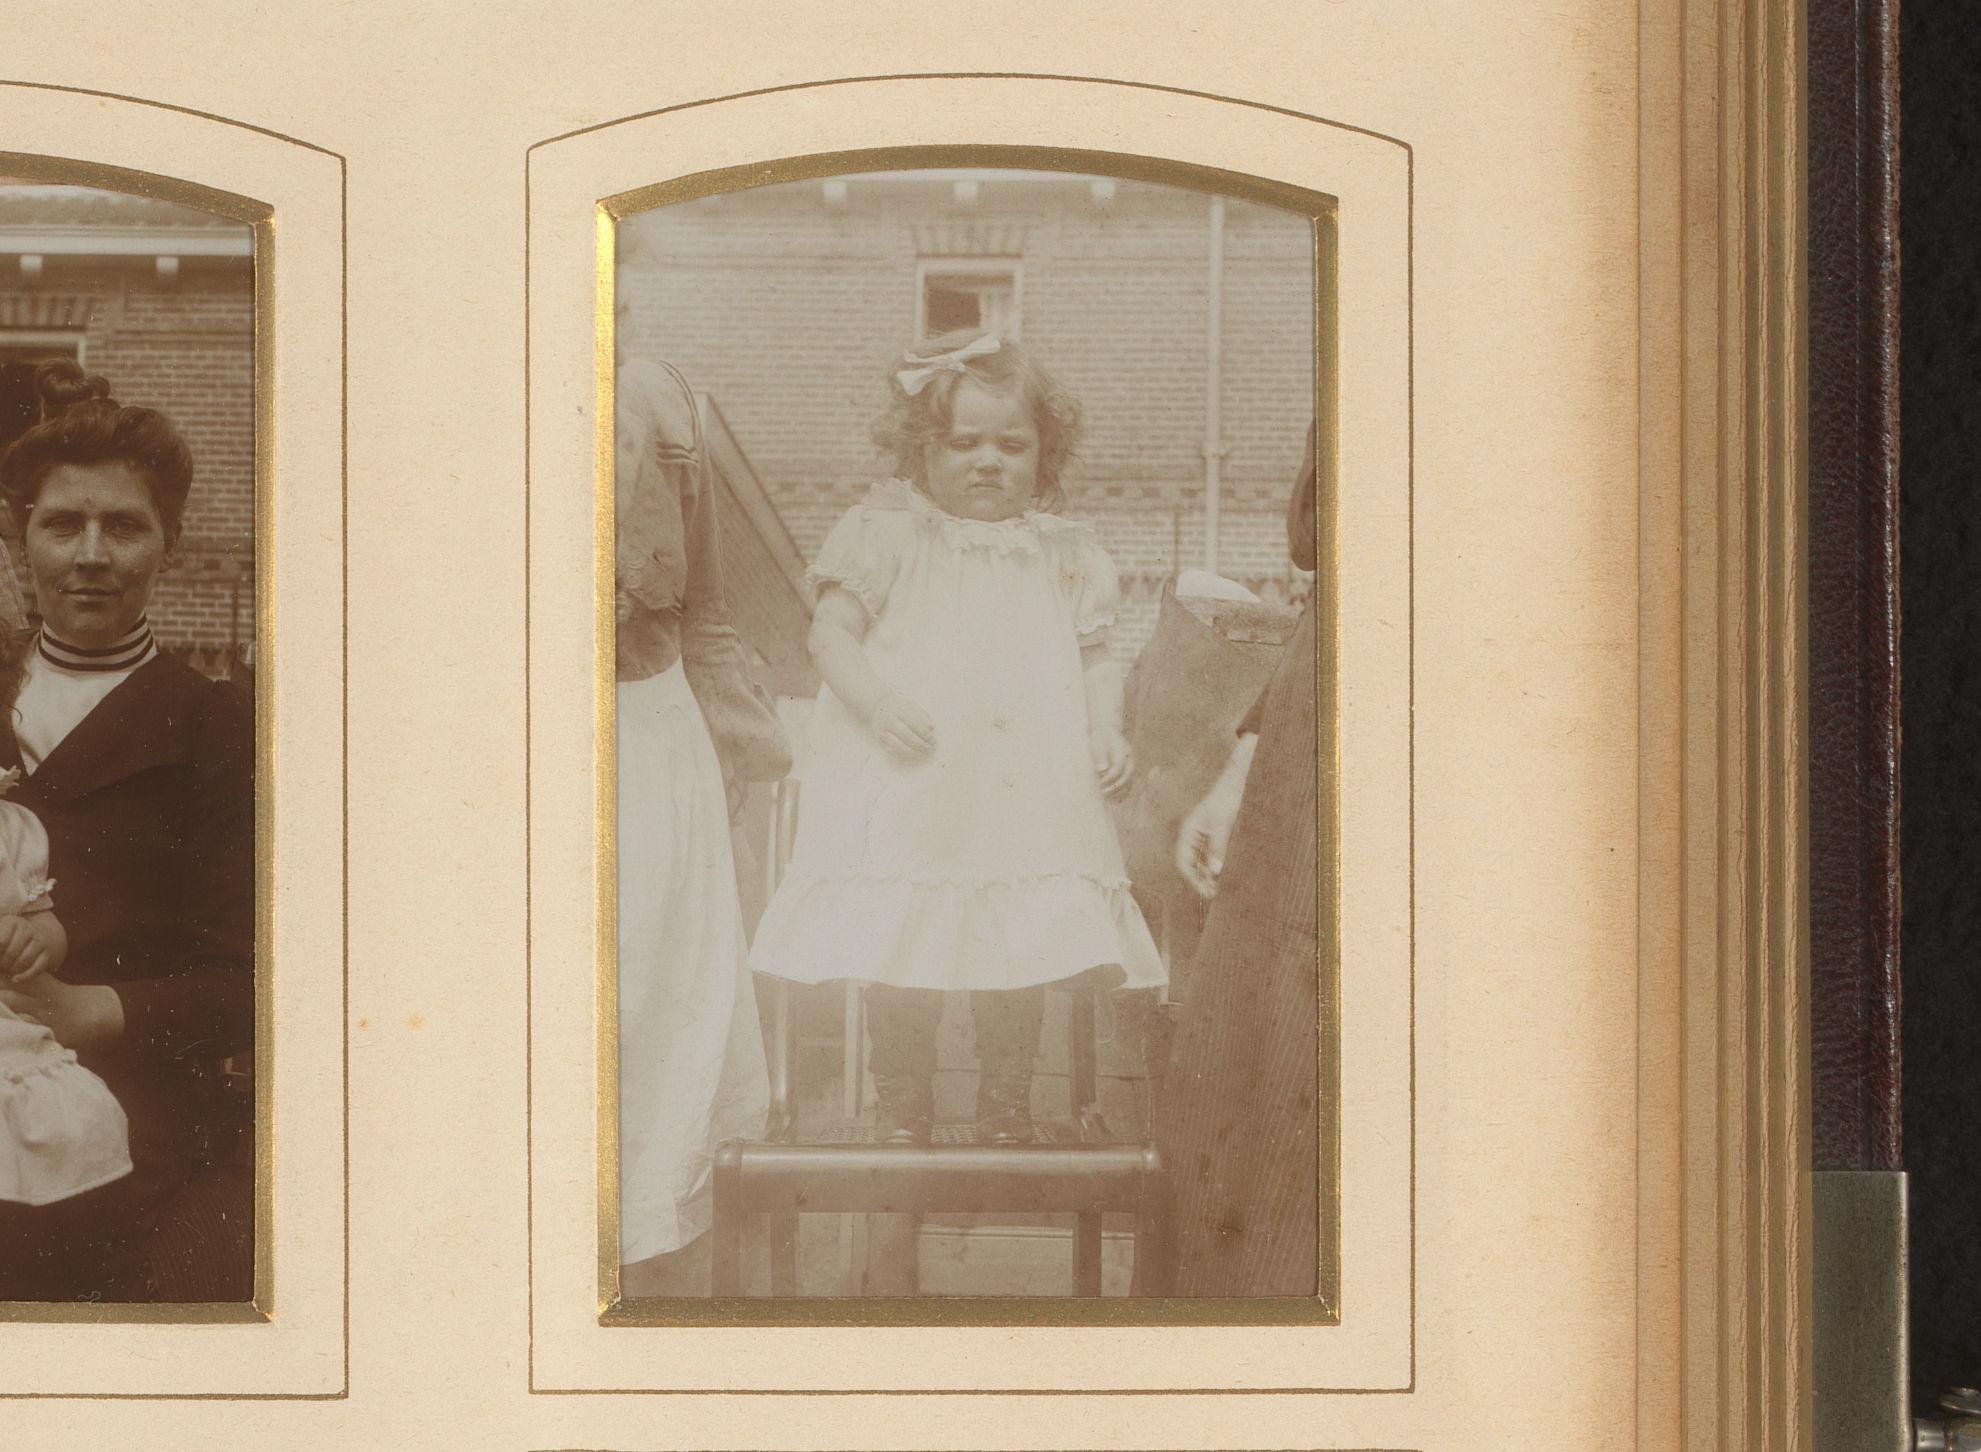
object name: album leaf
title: Portret van een meisje, staand op een stoel in een tuin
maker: Anonymous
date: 1900-1910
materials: photographic support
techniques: collodion silver print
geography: netherlands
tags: historical persons - bb - woman, garden, toddler (female), chair